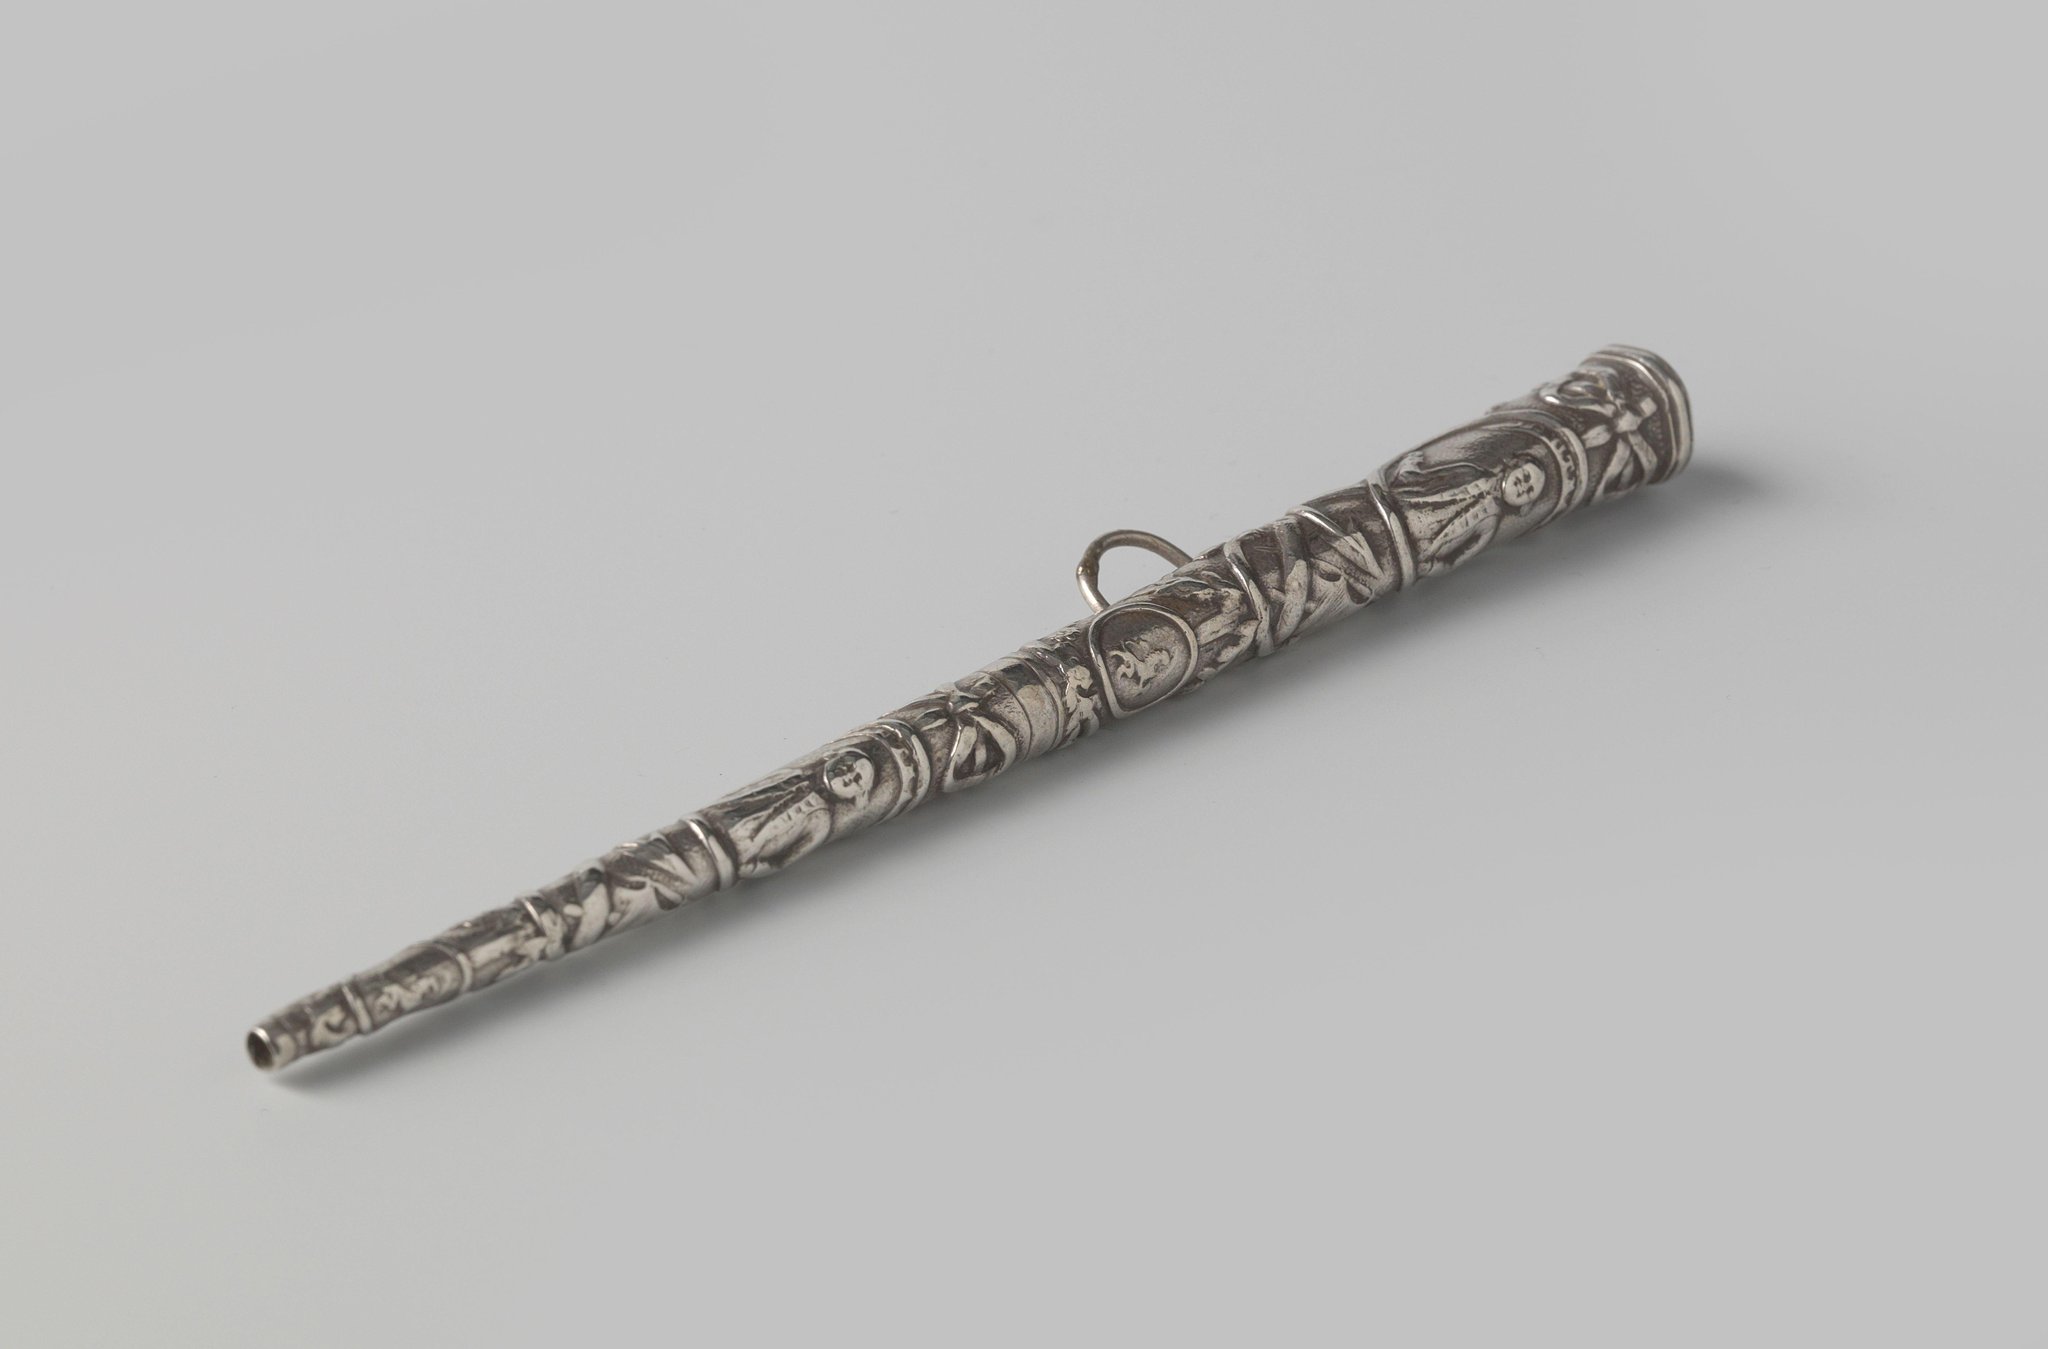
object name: breinaaldenschede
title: Breinaaldenschede ter herinnering aan de Slag bij de Doggersbank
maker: isaac lingenaar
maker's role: silversmith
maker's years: 1730-1805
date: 1781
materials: silver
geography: amsterdam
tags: the hague, johan arnold zoutman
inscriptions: town mark, maker's mark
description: De ronde, taps toelopende schede heeft een geprofileerde bovenrand en een dichte bovenzijde met een kleine ronde opening voor de breinaald. Hij is geheel versierd in stampwerktechniek met twee gelijke, door een strik bekroonde medaillons met het borstbeeld van schout-bij-nacht Arnold Zoutman, waarboven de naam Zoutman. Onder elk medaillon bevindt zich een trofee van een anker, een pijl en een hellebaard, boven een elkaar kruisend anker en vlag op een geruwde grond. Hieronder hangt voor en achter een guirlande met daaraan een medaillon met de Nederlandse leeuw met het zwaard en de zeven pijlen. Daaronder bevindt zich een rand van C-voluten, aan de onderzijde afgesloten door een gladde band. Hieronder wordt de gehele versiering herhaald. Op een derde van de hoogte is een oog met een ring bevestigd.